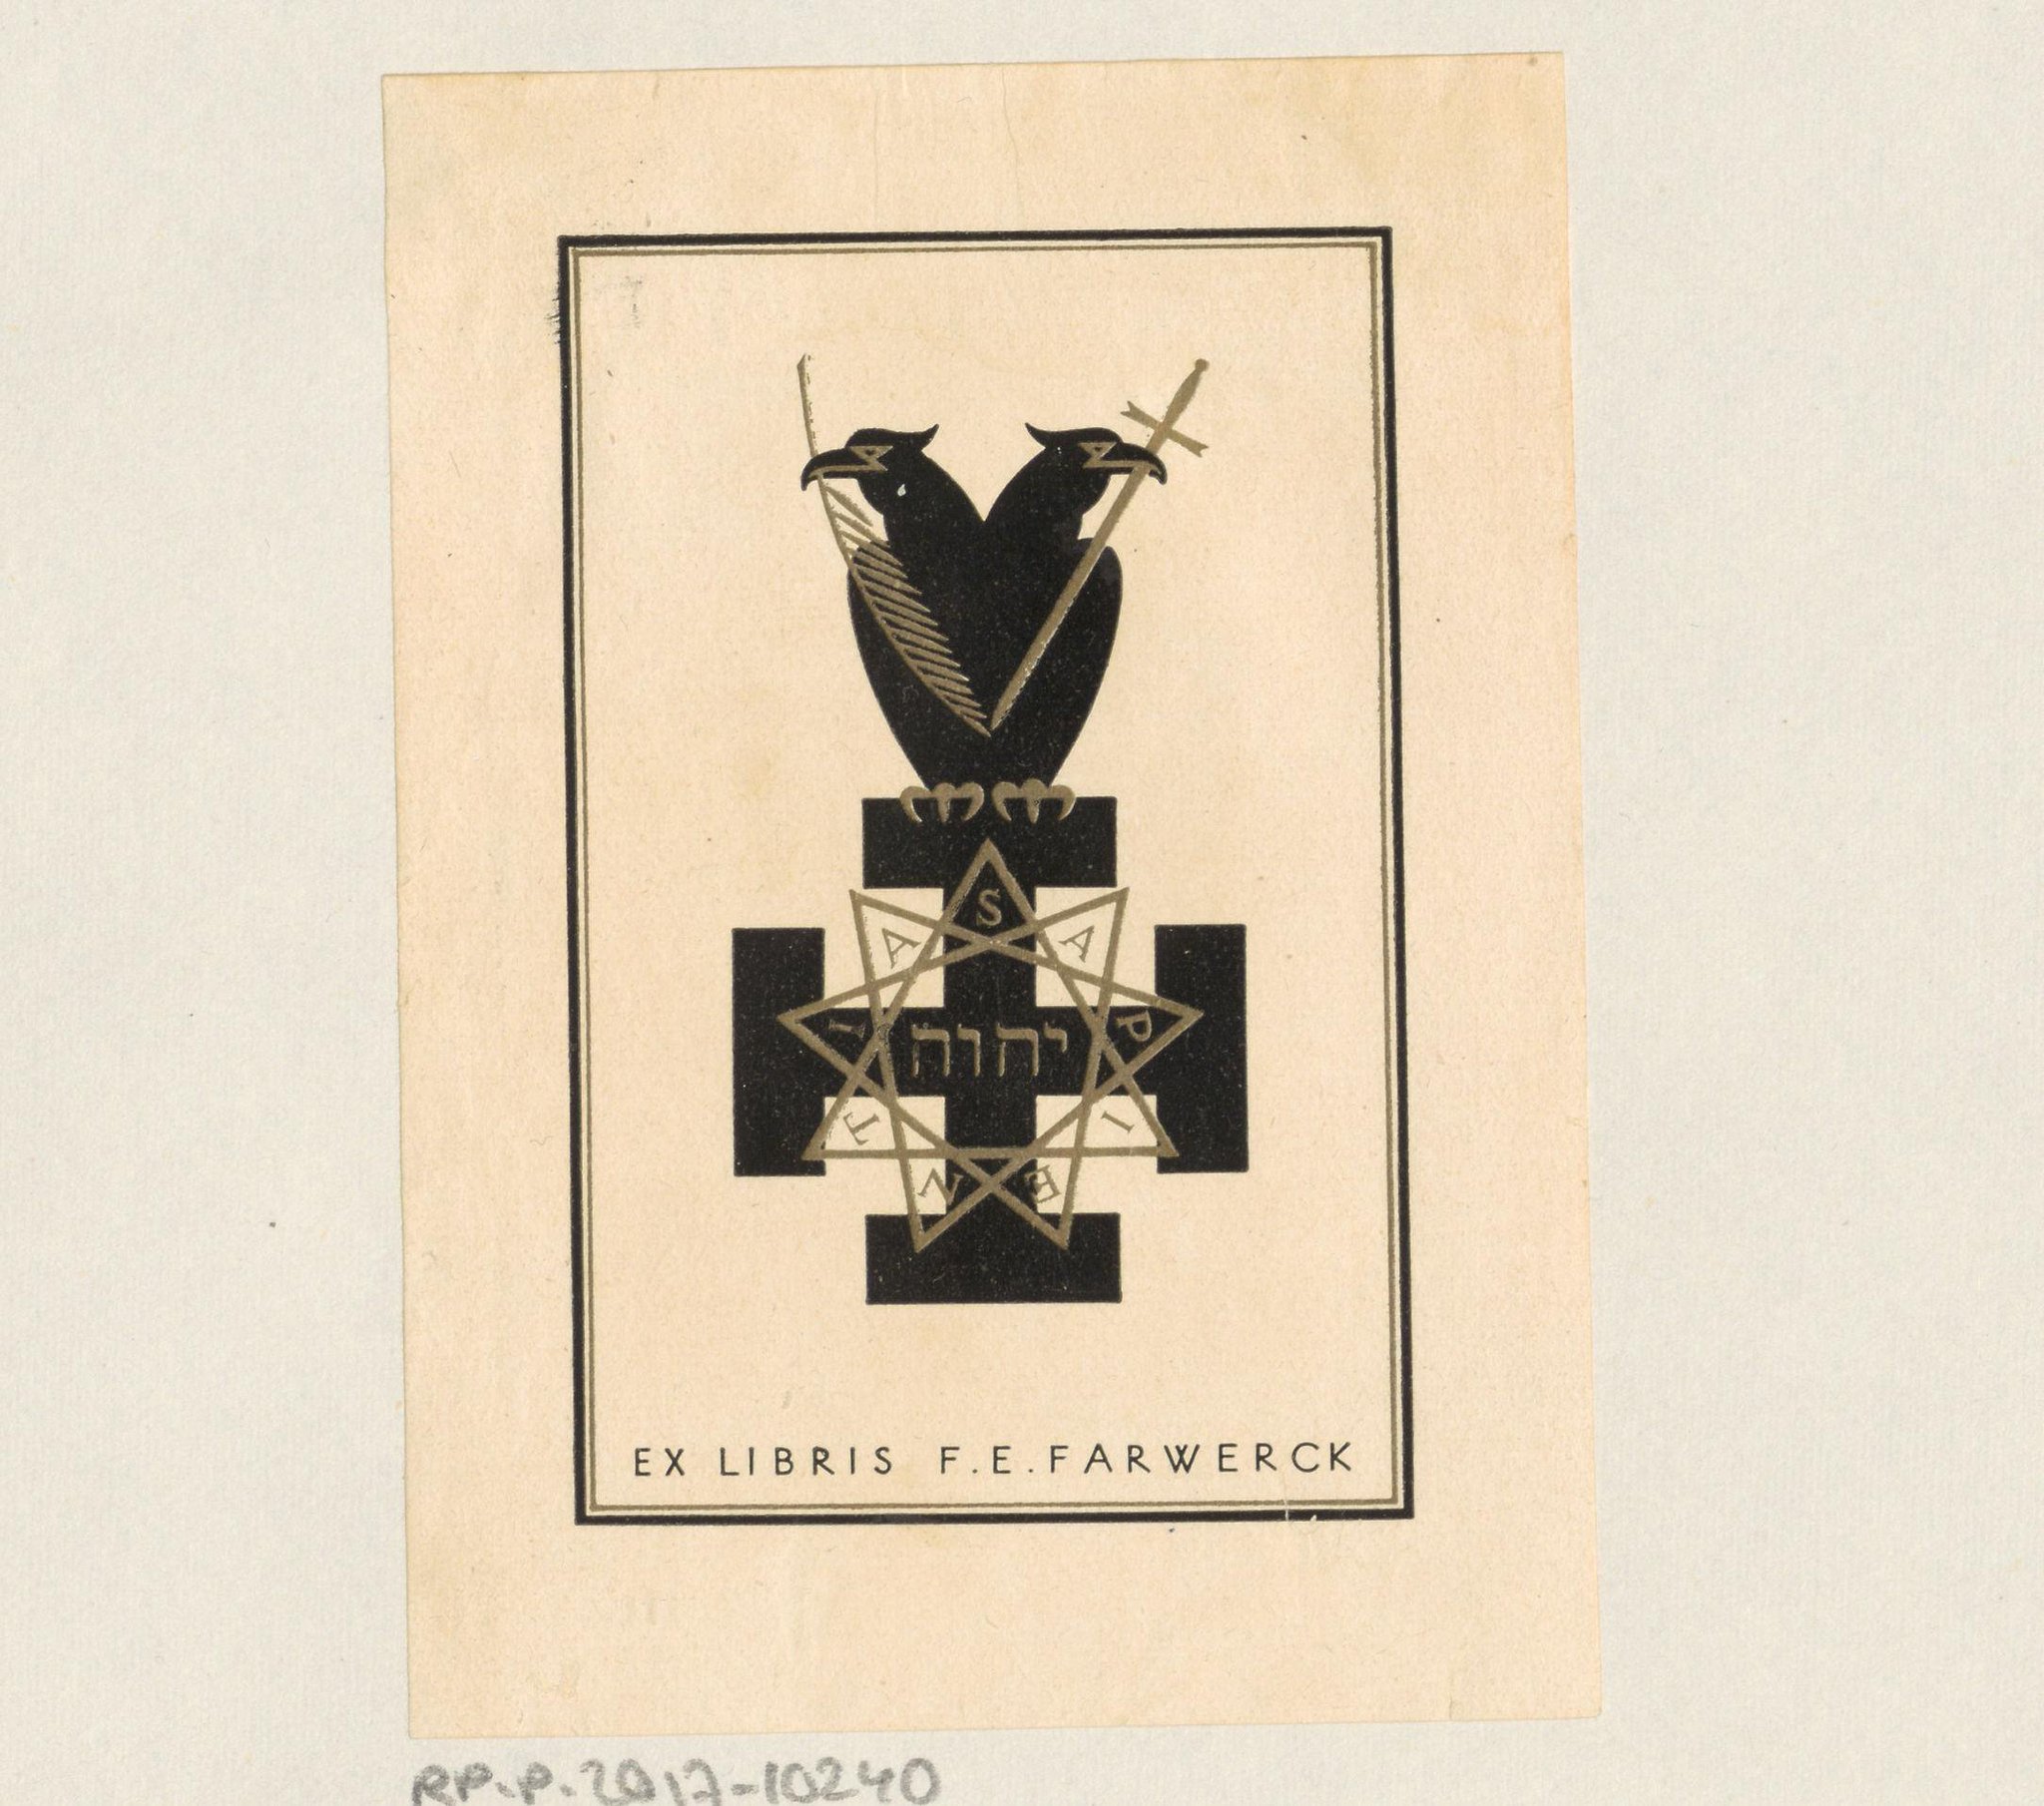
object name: bookplate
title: Ex libris van Frans Eduard Farwerck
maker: Anonymous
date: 1927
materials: paper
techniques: printing block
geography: germany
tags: amsterdam, predatory birds: eagle, hacking and thrusting weapons: sword